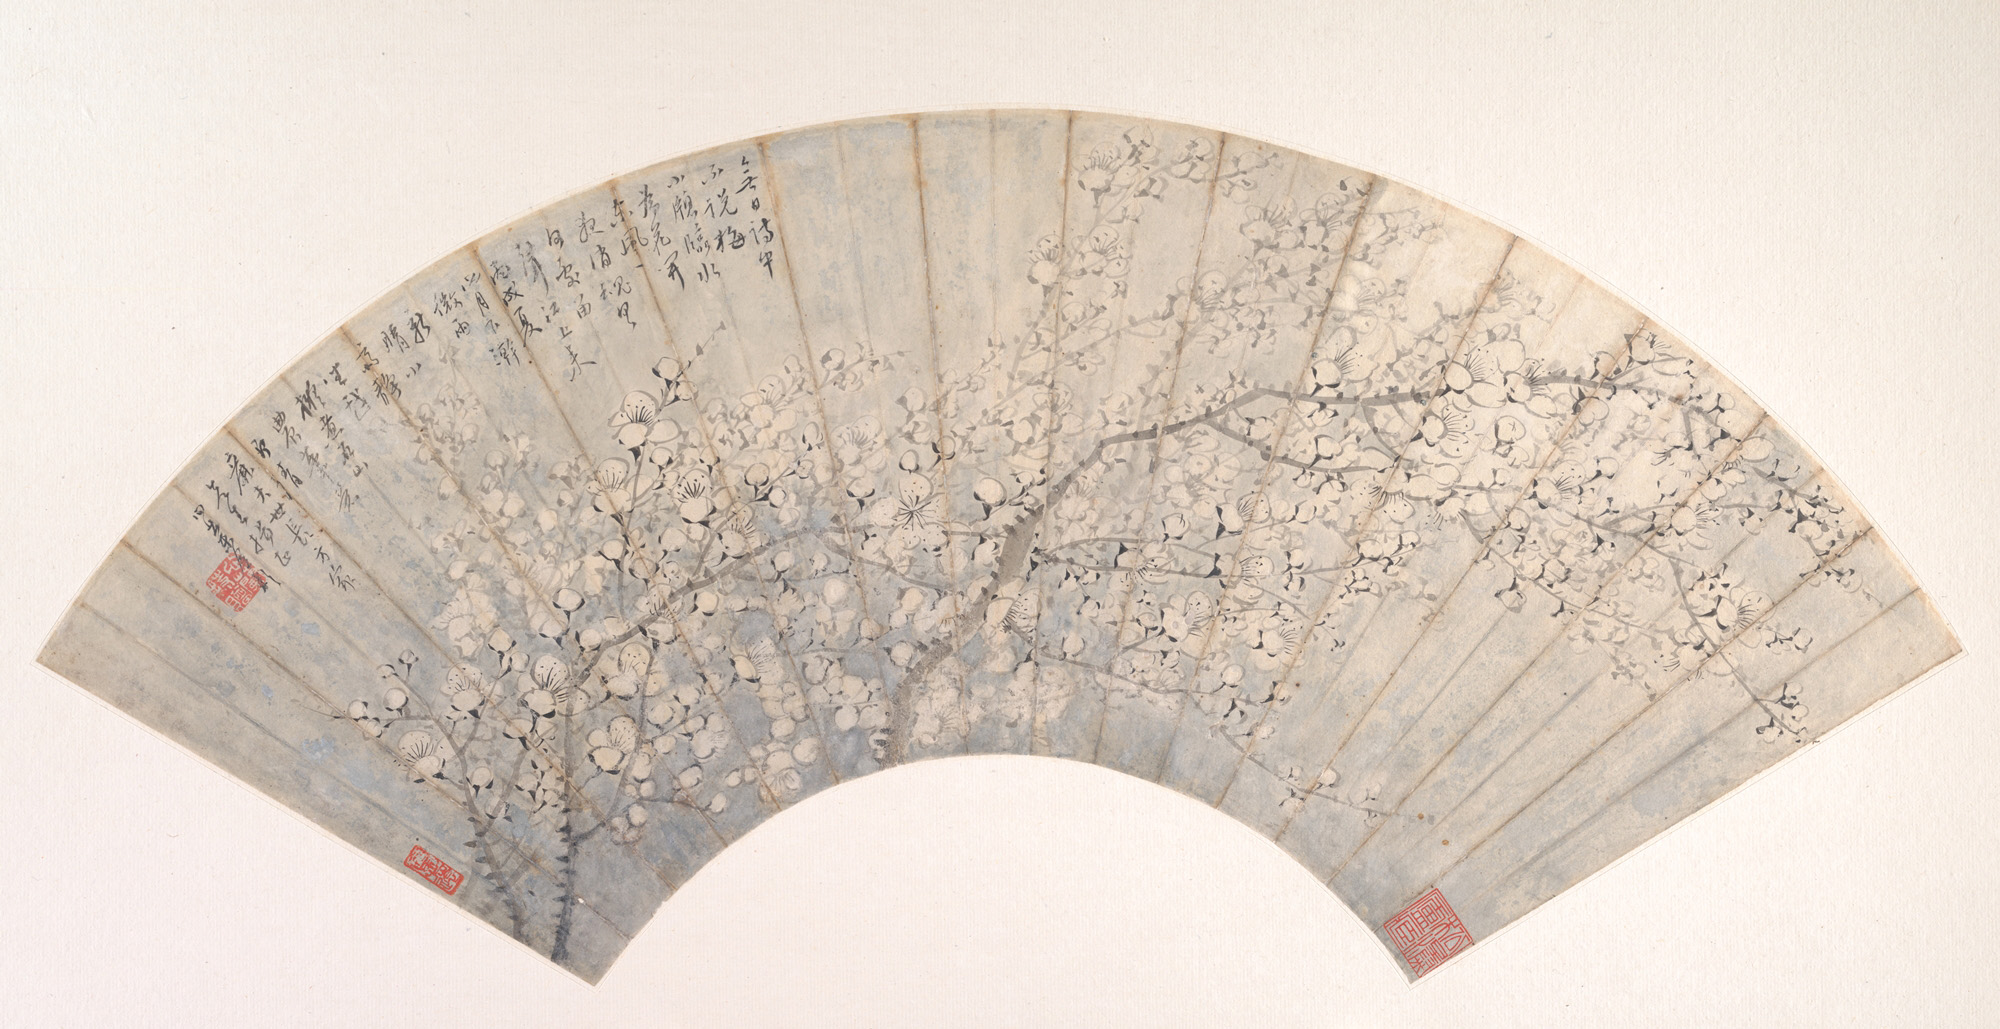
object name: folding fan mounted a an album leaf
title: Plum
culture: chinese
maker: jin lan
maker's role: artist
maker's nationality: chinese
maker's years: 1841-1910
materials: ink, paper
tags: trees